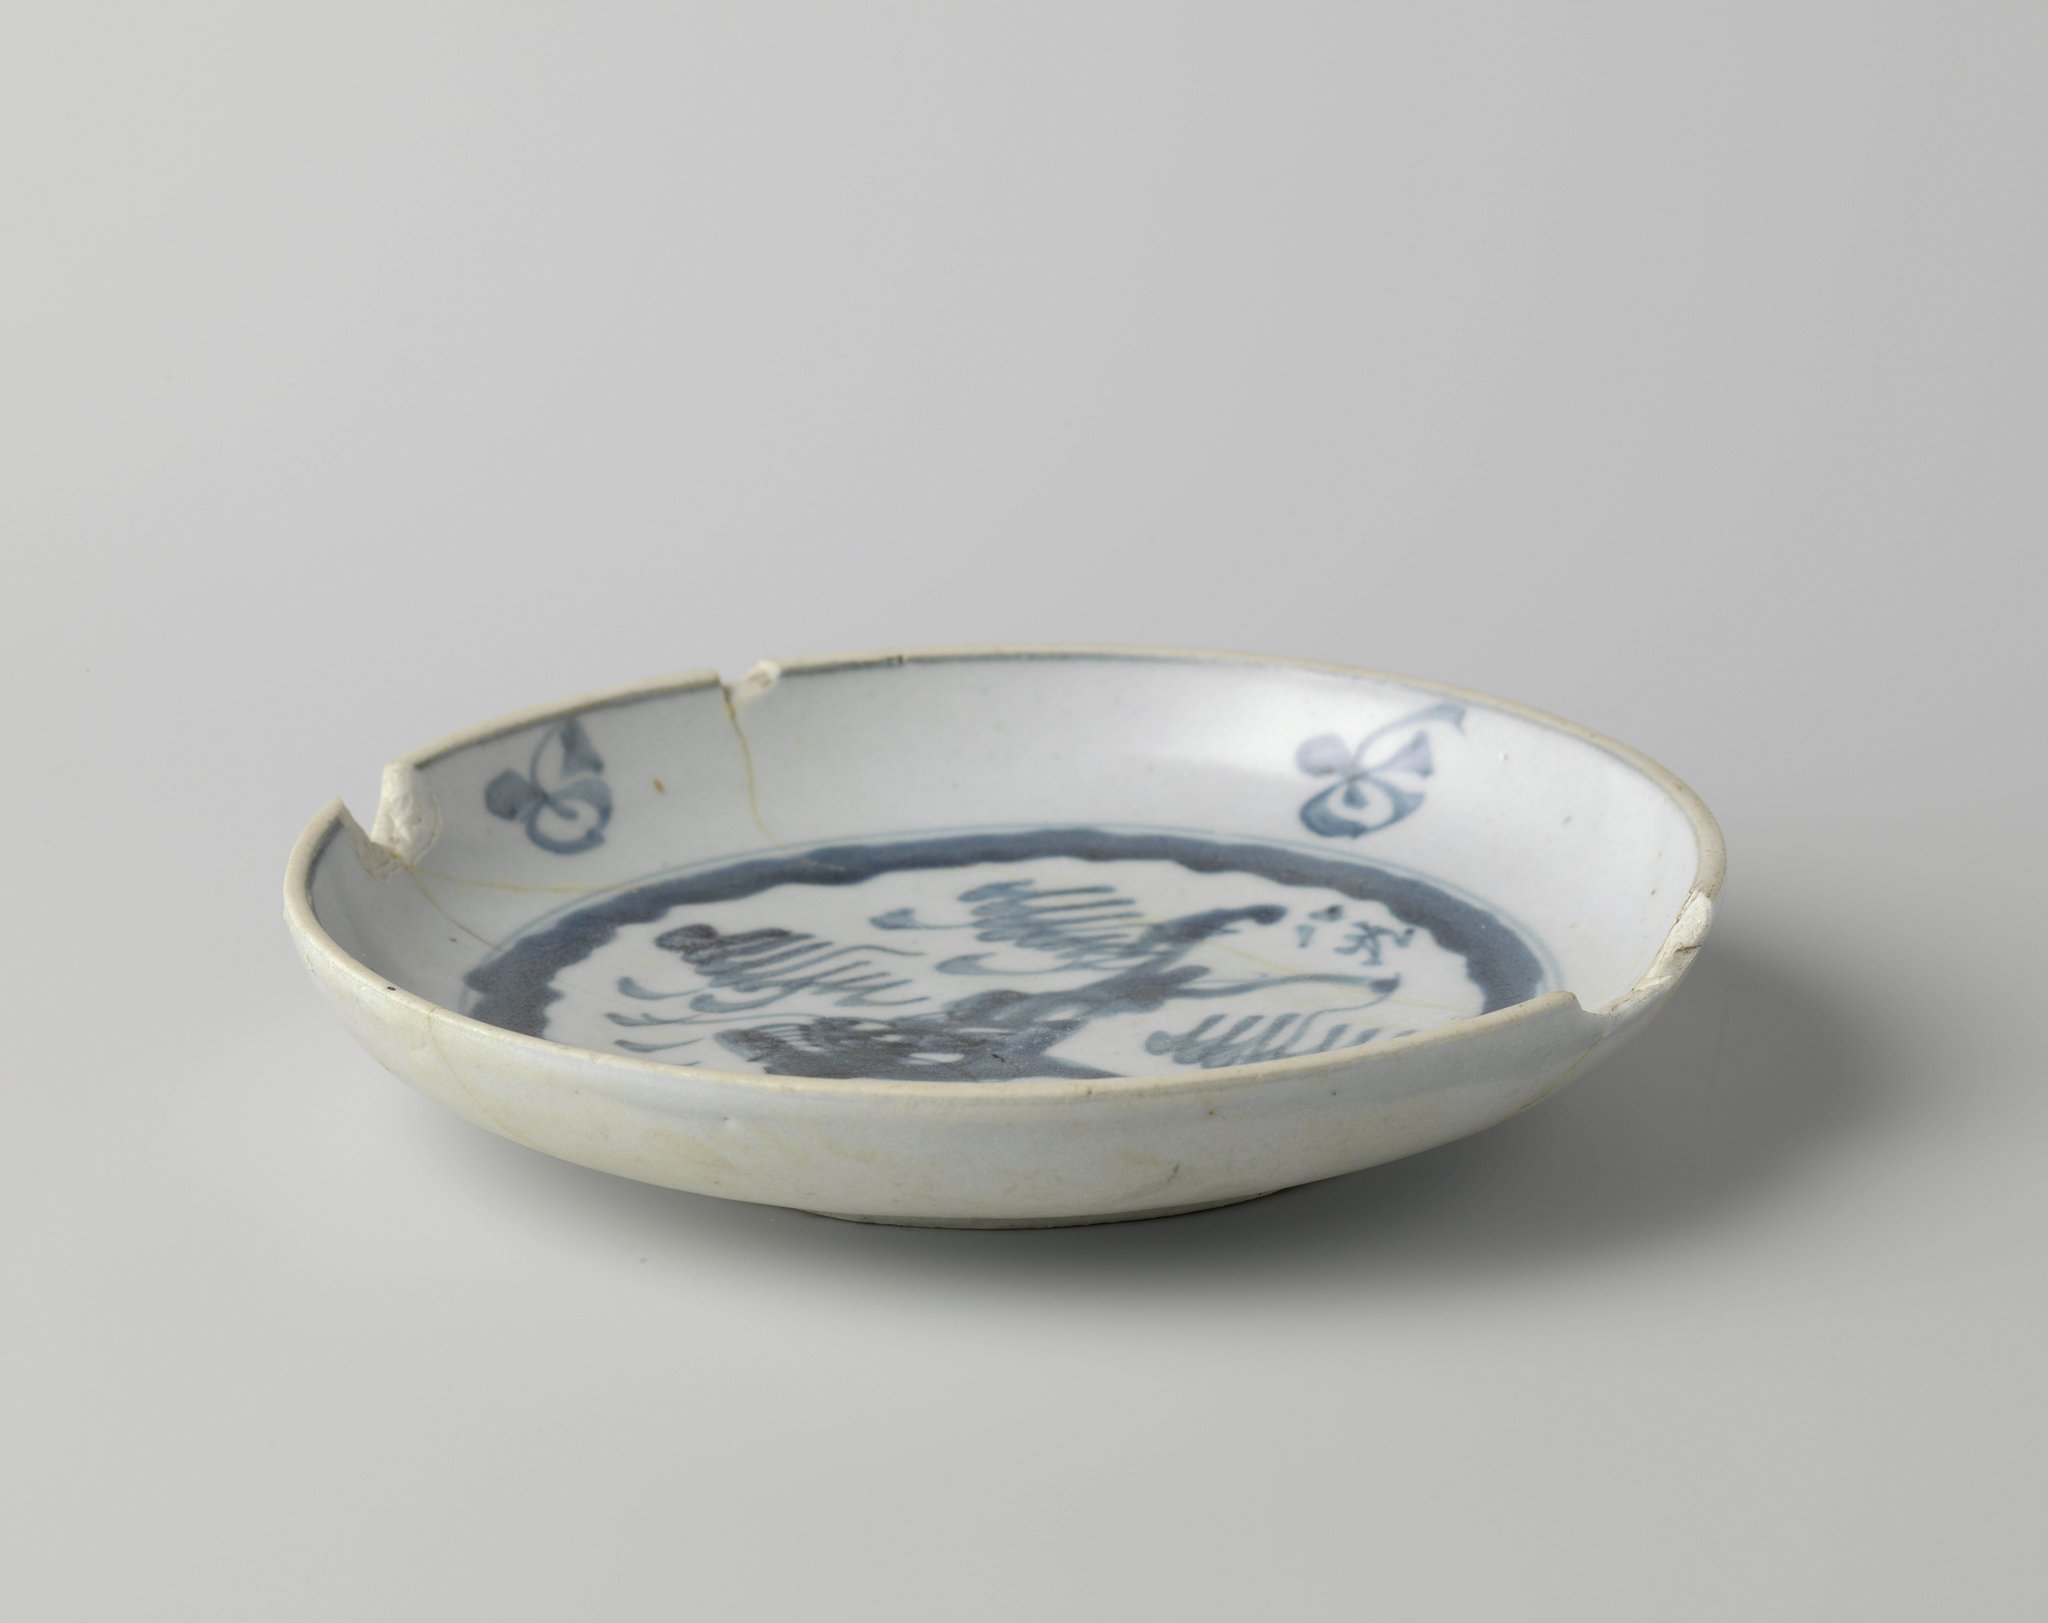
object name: plate dish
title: Bord uit V.O.C.-schip de 'Witte Leeuw'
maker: Anonymous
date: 1613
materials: porcelain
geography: shantou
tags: verenigde oostindische compagnie, sint-helena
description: A complete dish. In the centre a sketched qilin with flames. The walls are blank except for four peach-like designs. The outside is undecorated.